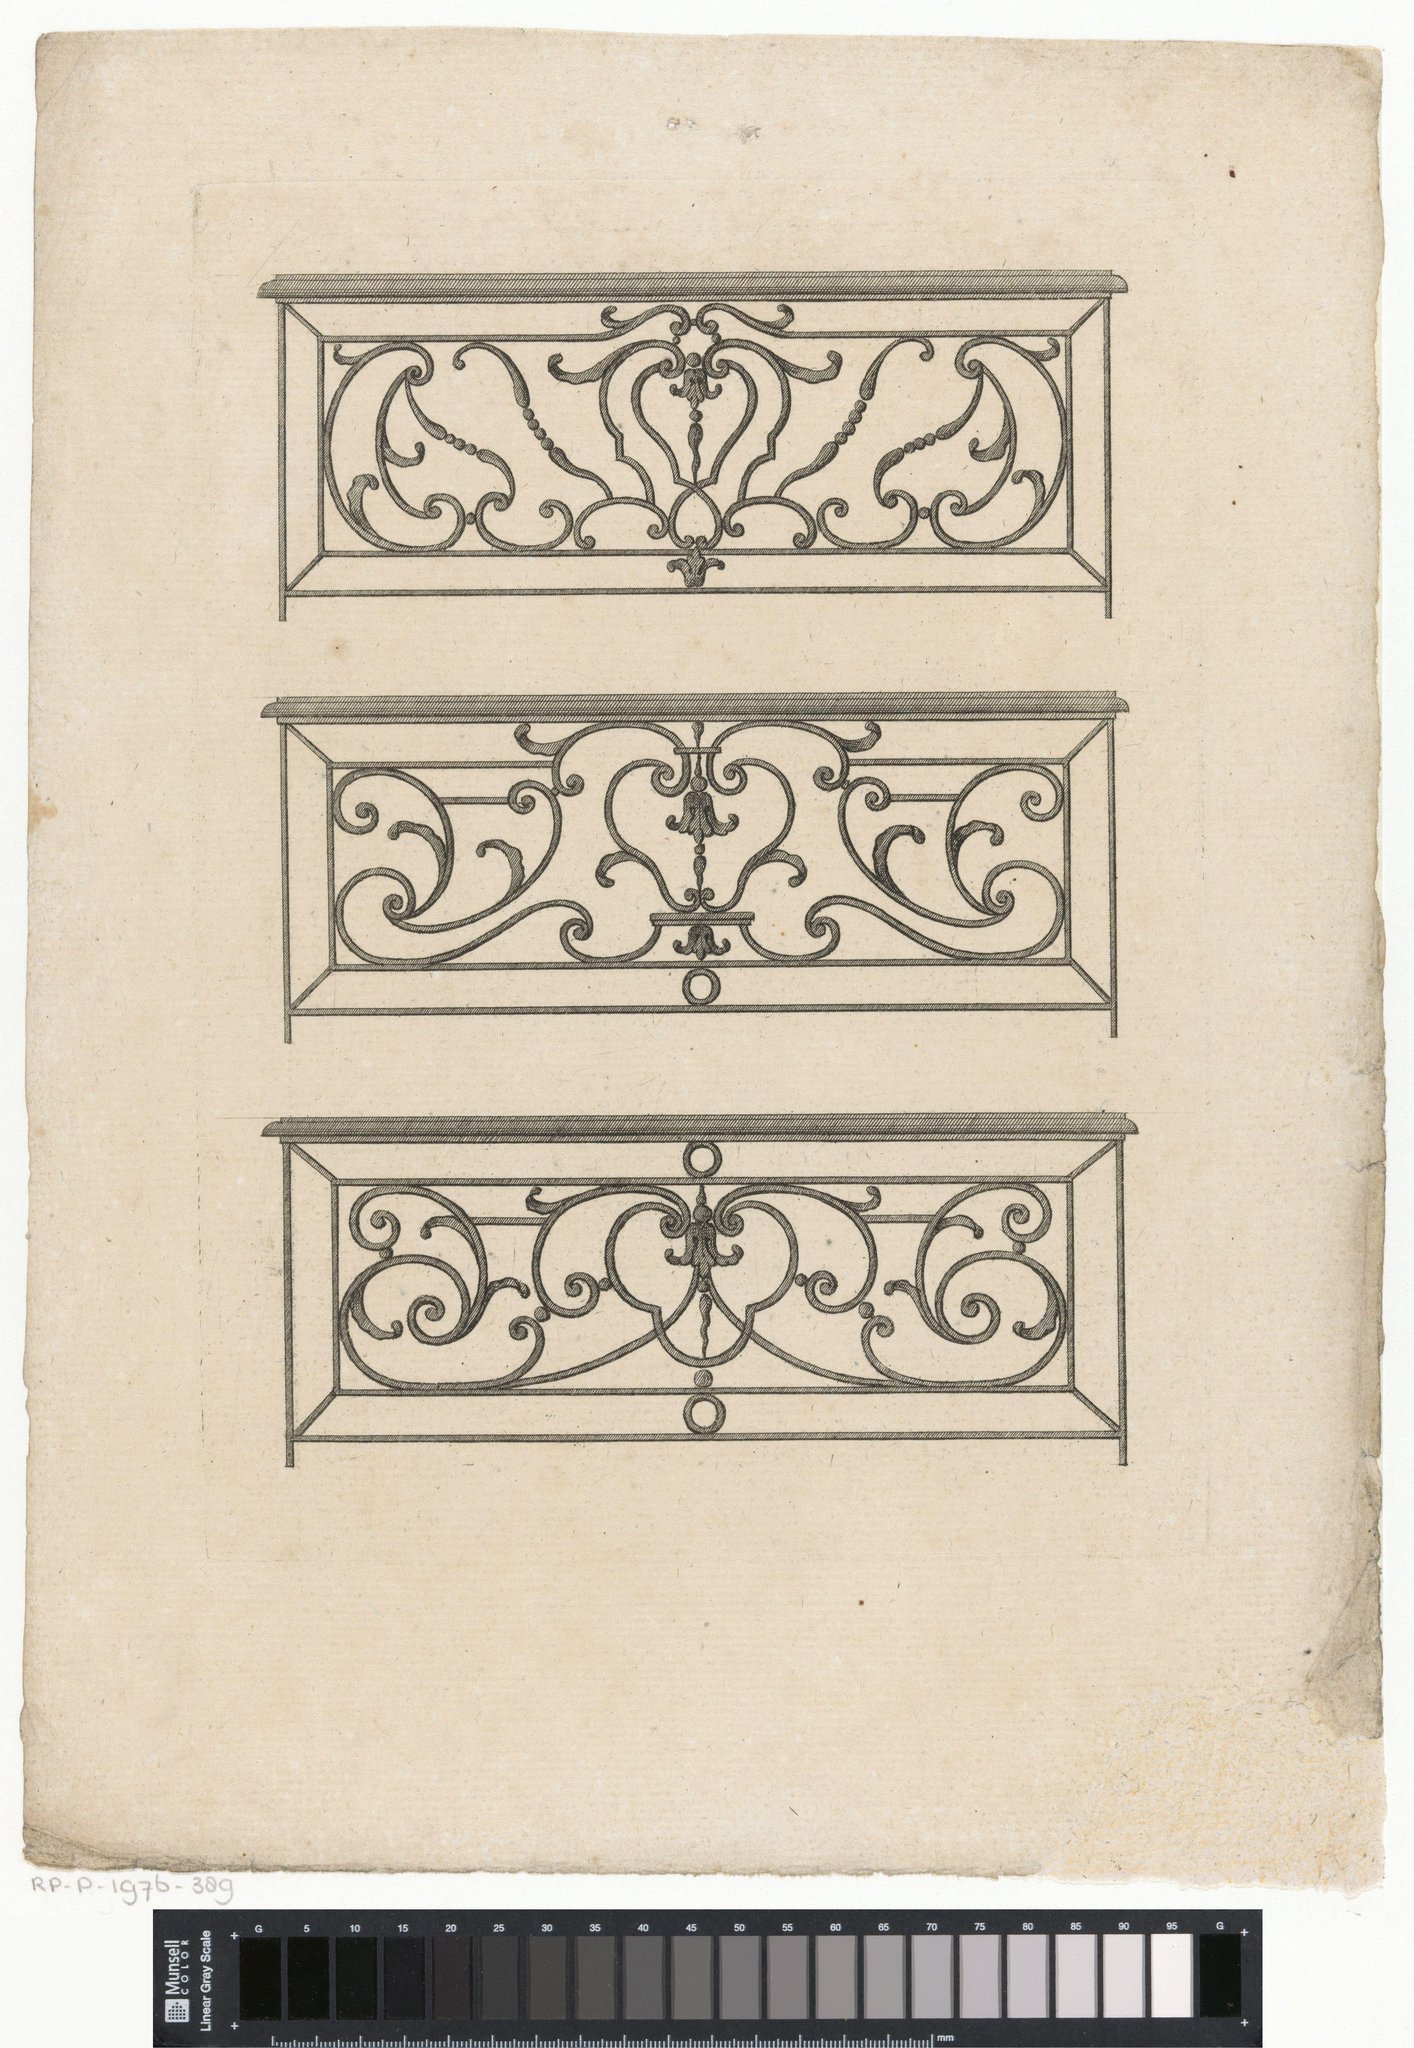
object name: print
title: Balcon d'un nouveau gout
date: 1759-1784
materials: paper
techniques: etching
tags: balustrade, balcony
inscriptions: collector's mark: Lugt 2228